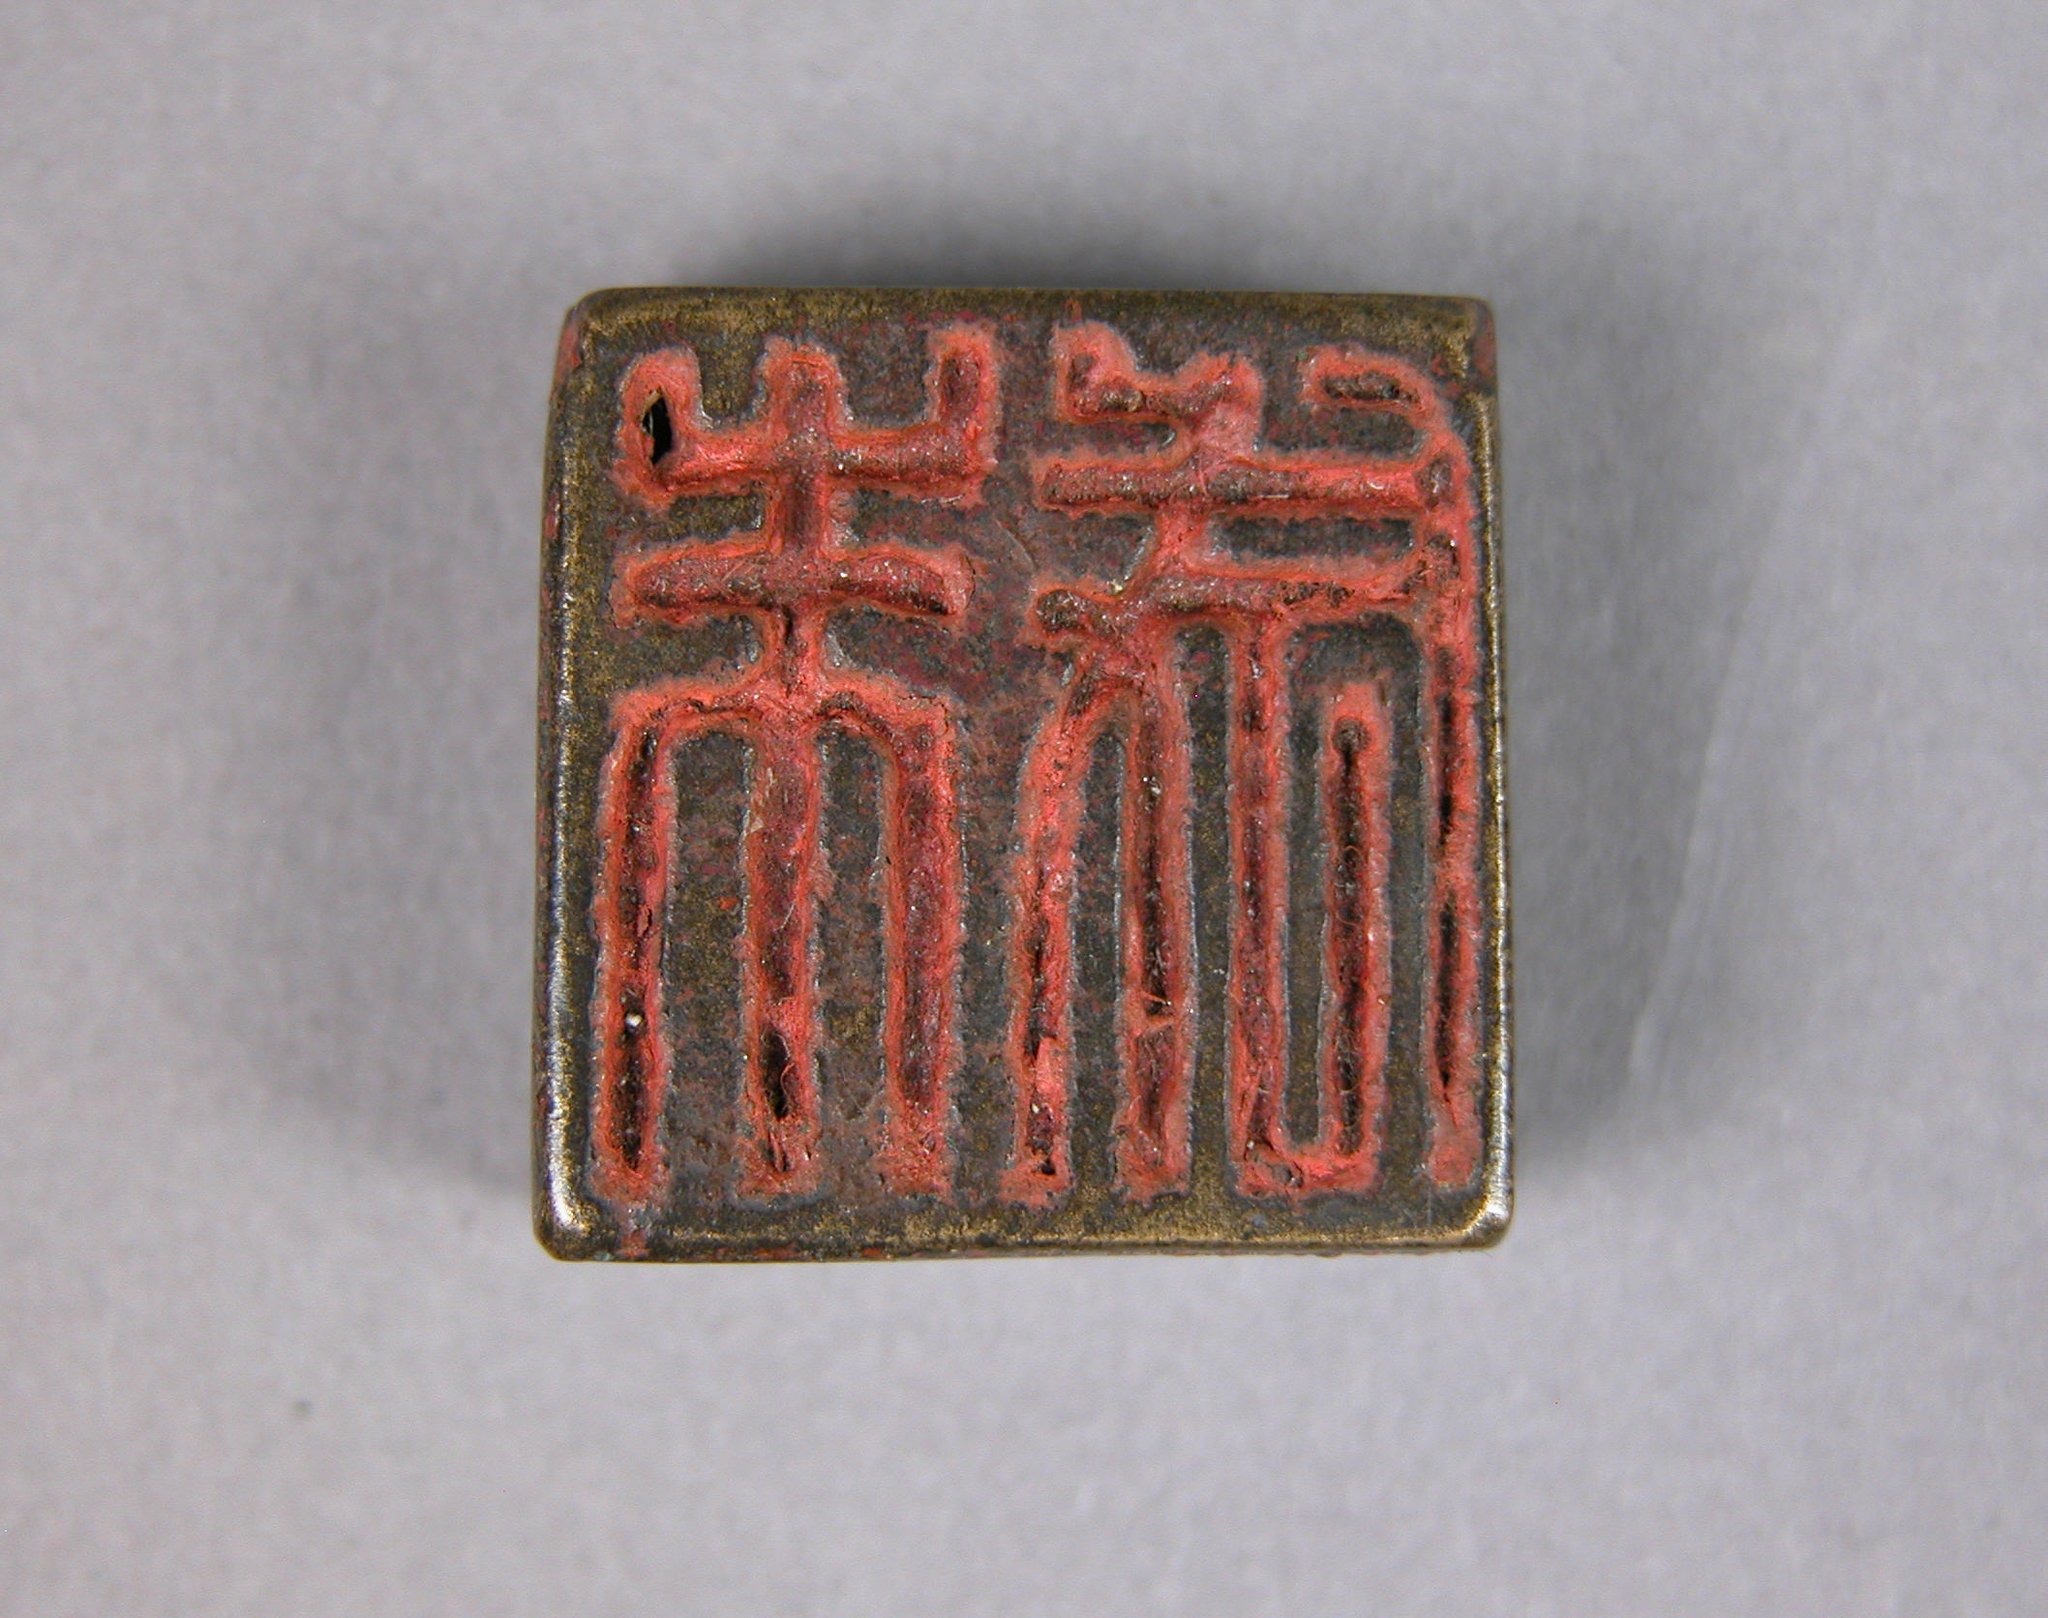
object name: seal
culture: chinese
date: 1300-1644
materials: bronze